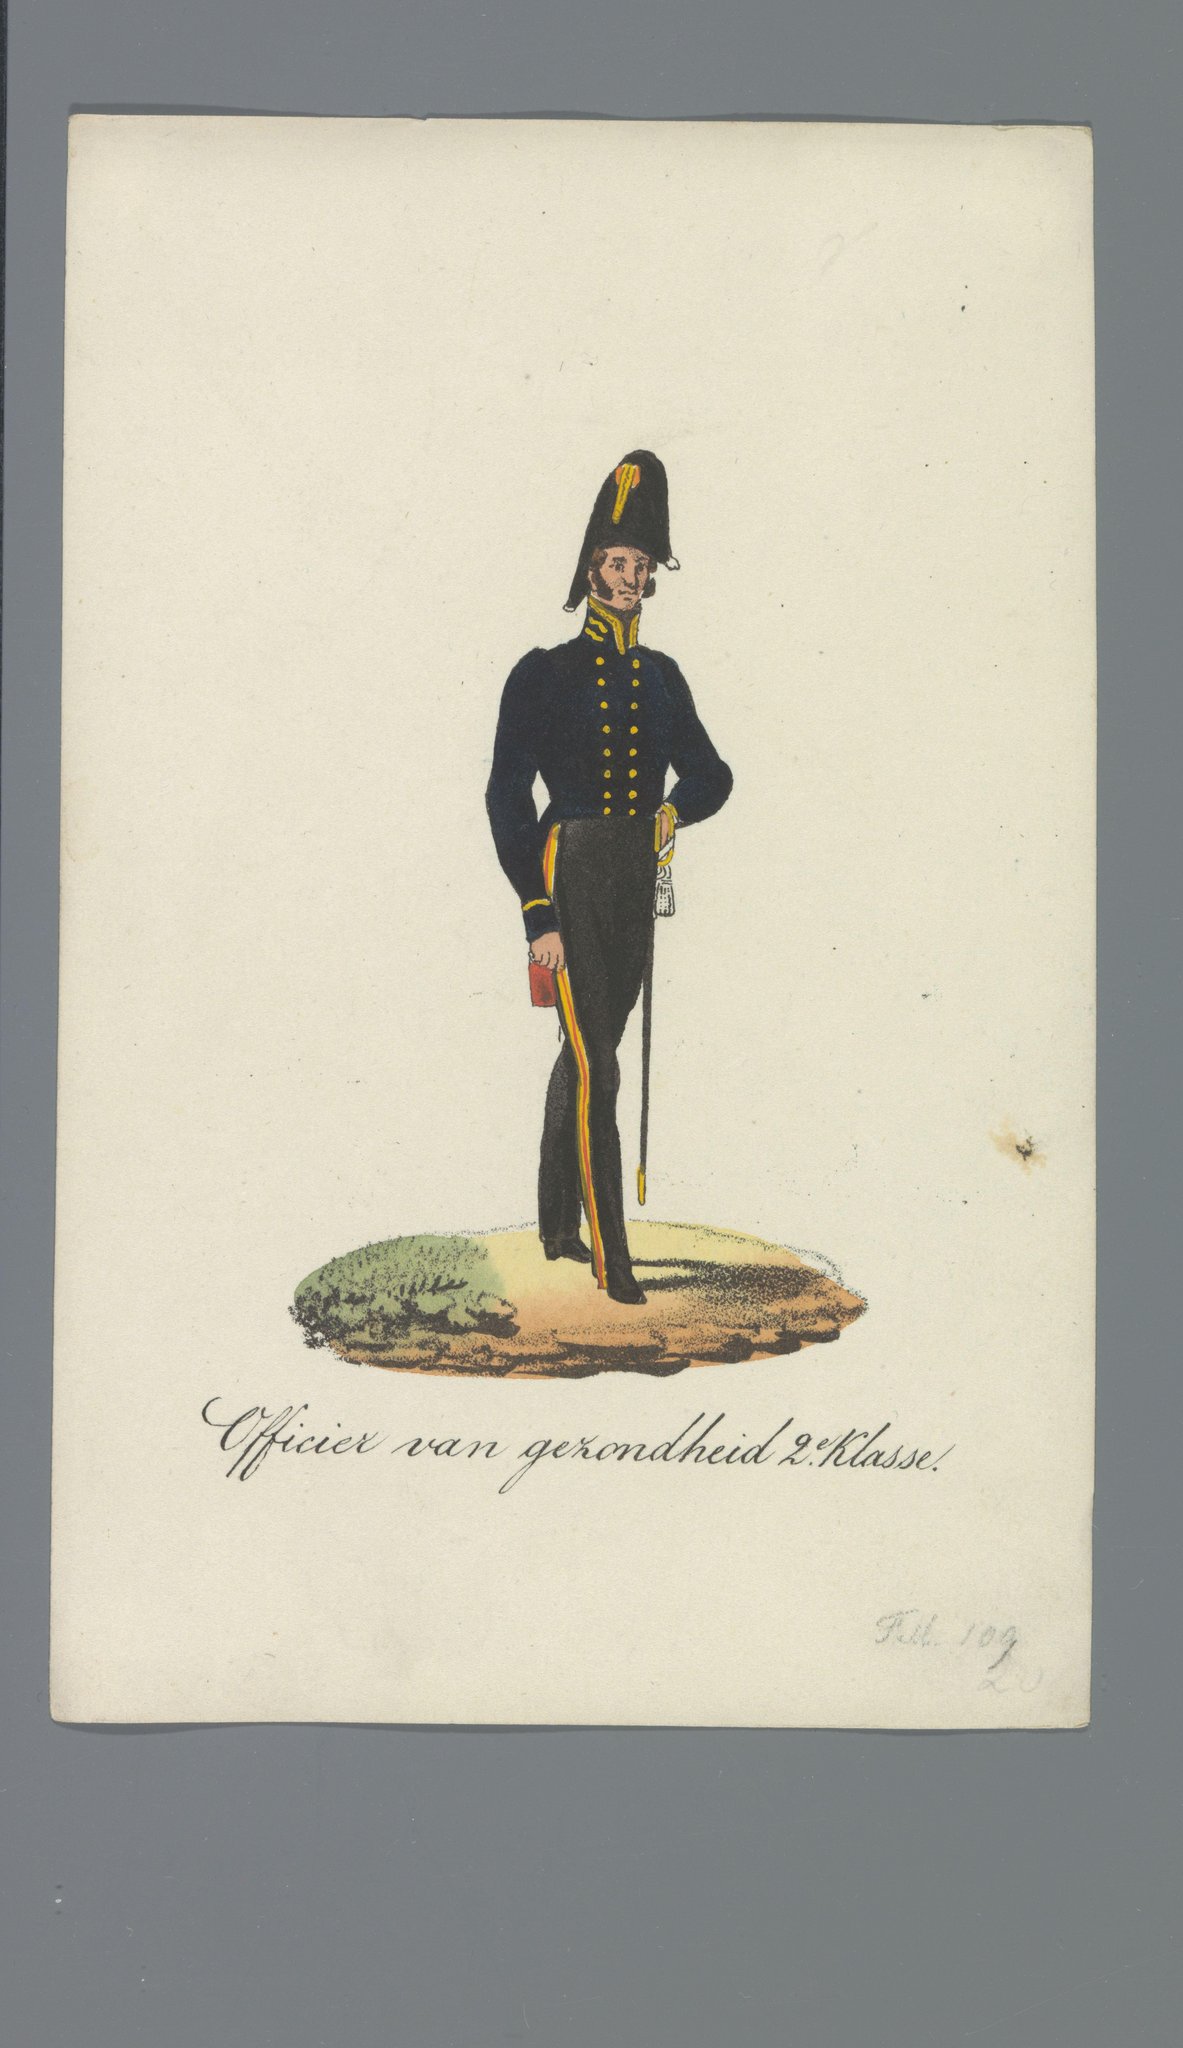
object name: print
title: Nederlandse militaire uniformen in de jaren 1830-1832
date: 1835-1850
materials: paper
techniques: hand coloring, lithograph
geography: netherlands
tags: (military) uniforms, clothes, costume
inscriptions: collector's mark: Lugt 2228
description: Een officier van gezondheid tweede klasse van de infanterie, te voet. Onderdeel van een serie van 157 losse bladen met Nederlandse militaire uniformen in de jaren 1830-1832.